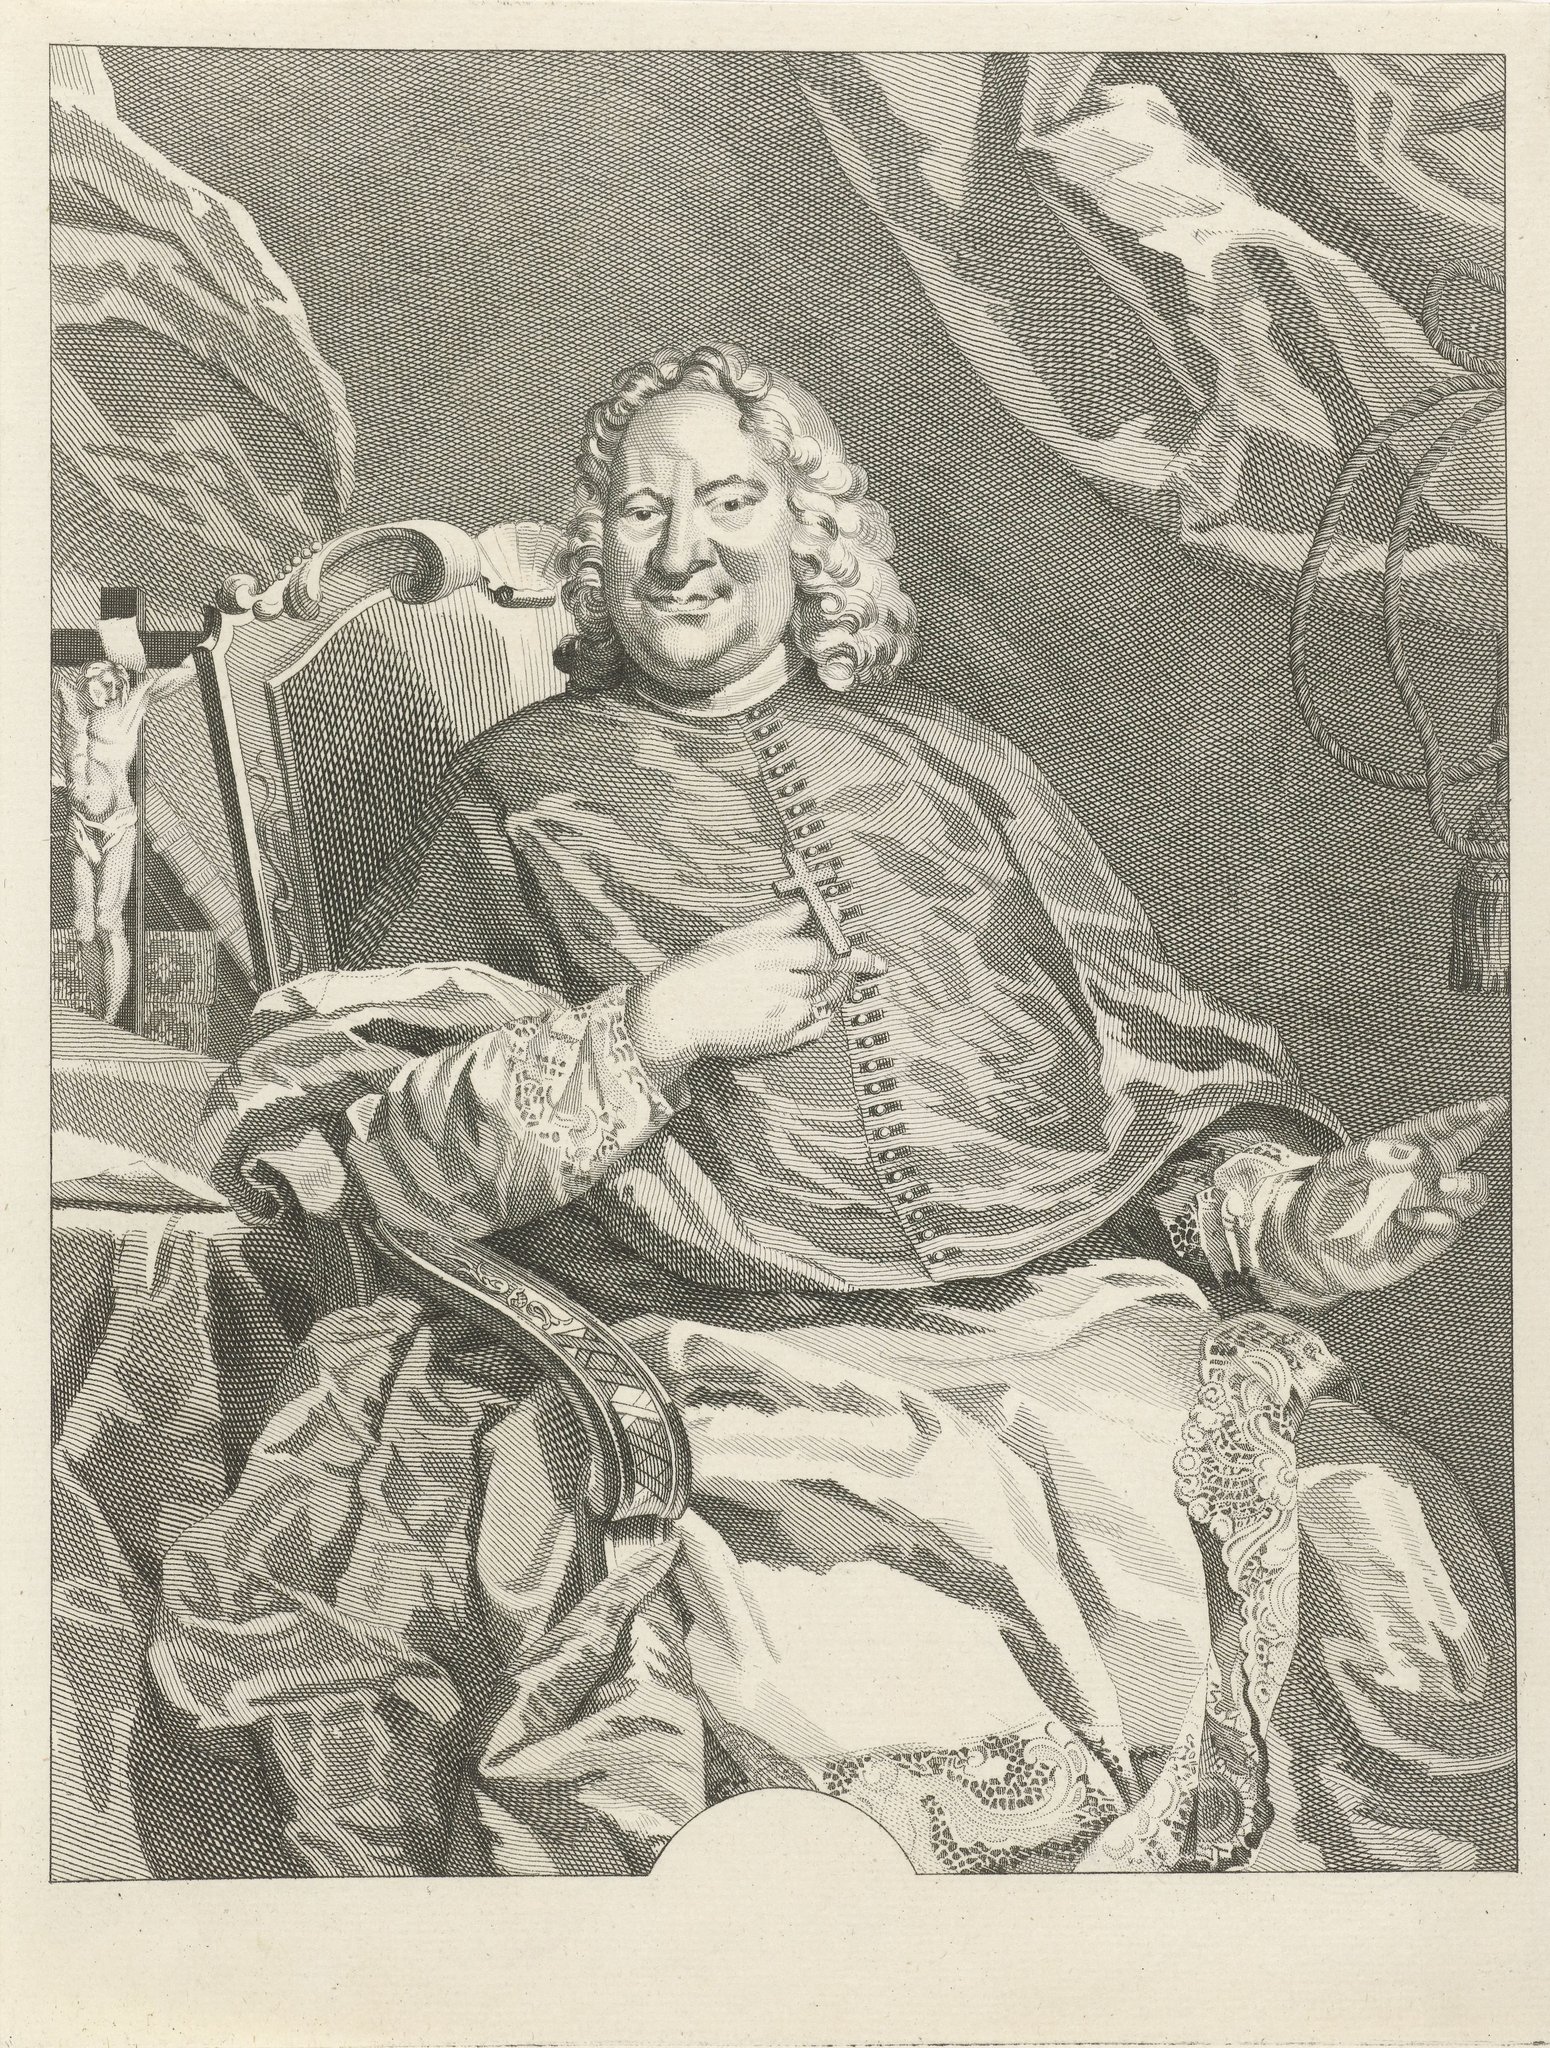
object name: print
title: Portret van een onbekende geestelijke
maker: jacob folkema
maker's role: draughtsman, print maker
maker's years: 1692-1767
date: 1702-1767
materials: paper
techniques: engraving, etching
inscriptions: collector's mark: Lugt 240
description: Portret van een onbekende geestelijke, blootshoofds. Kniestuk, zittend in een stoel naar rechts gedraaid. Met zijn linkerhand maakt de geestelijke een zegenend gebaar, zijn rechterhand rust op zijn borst.